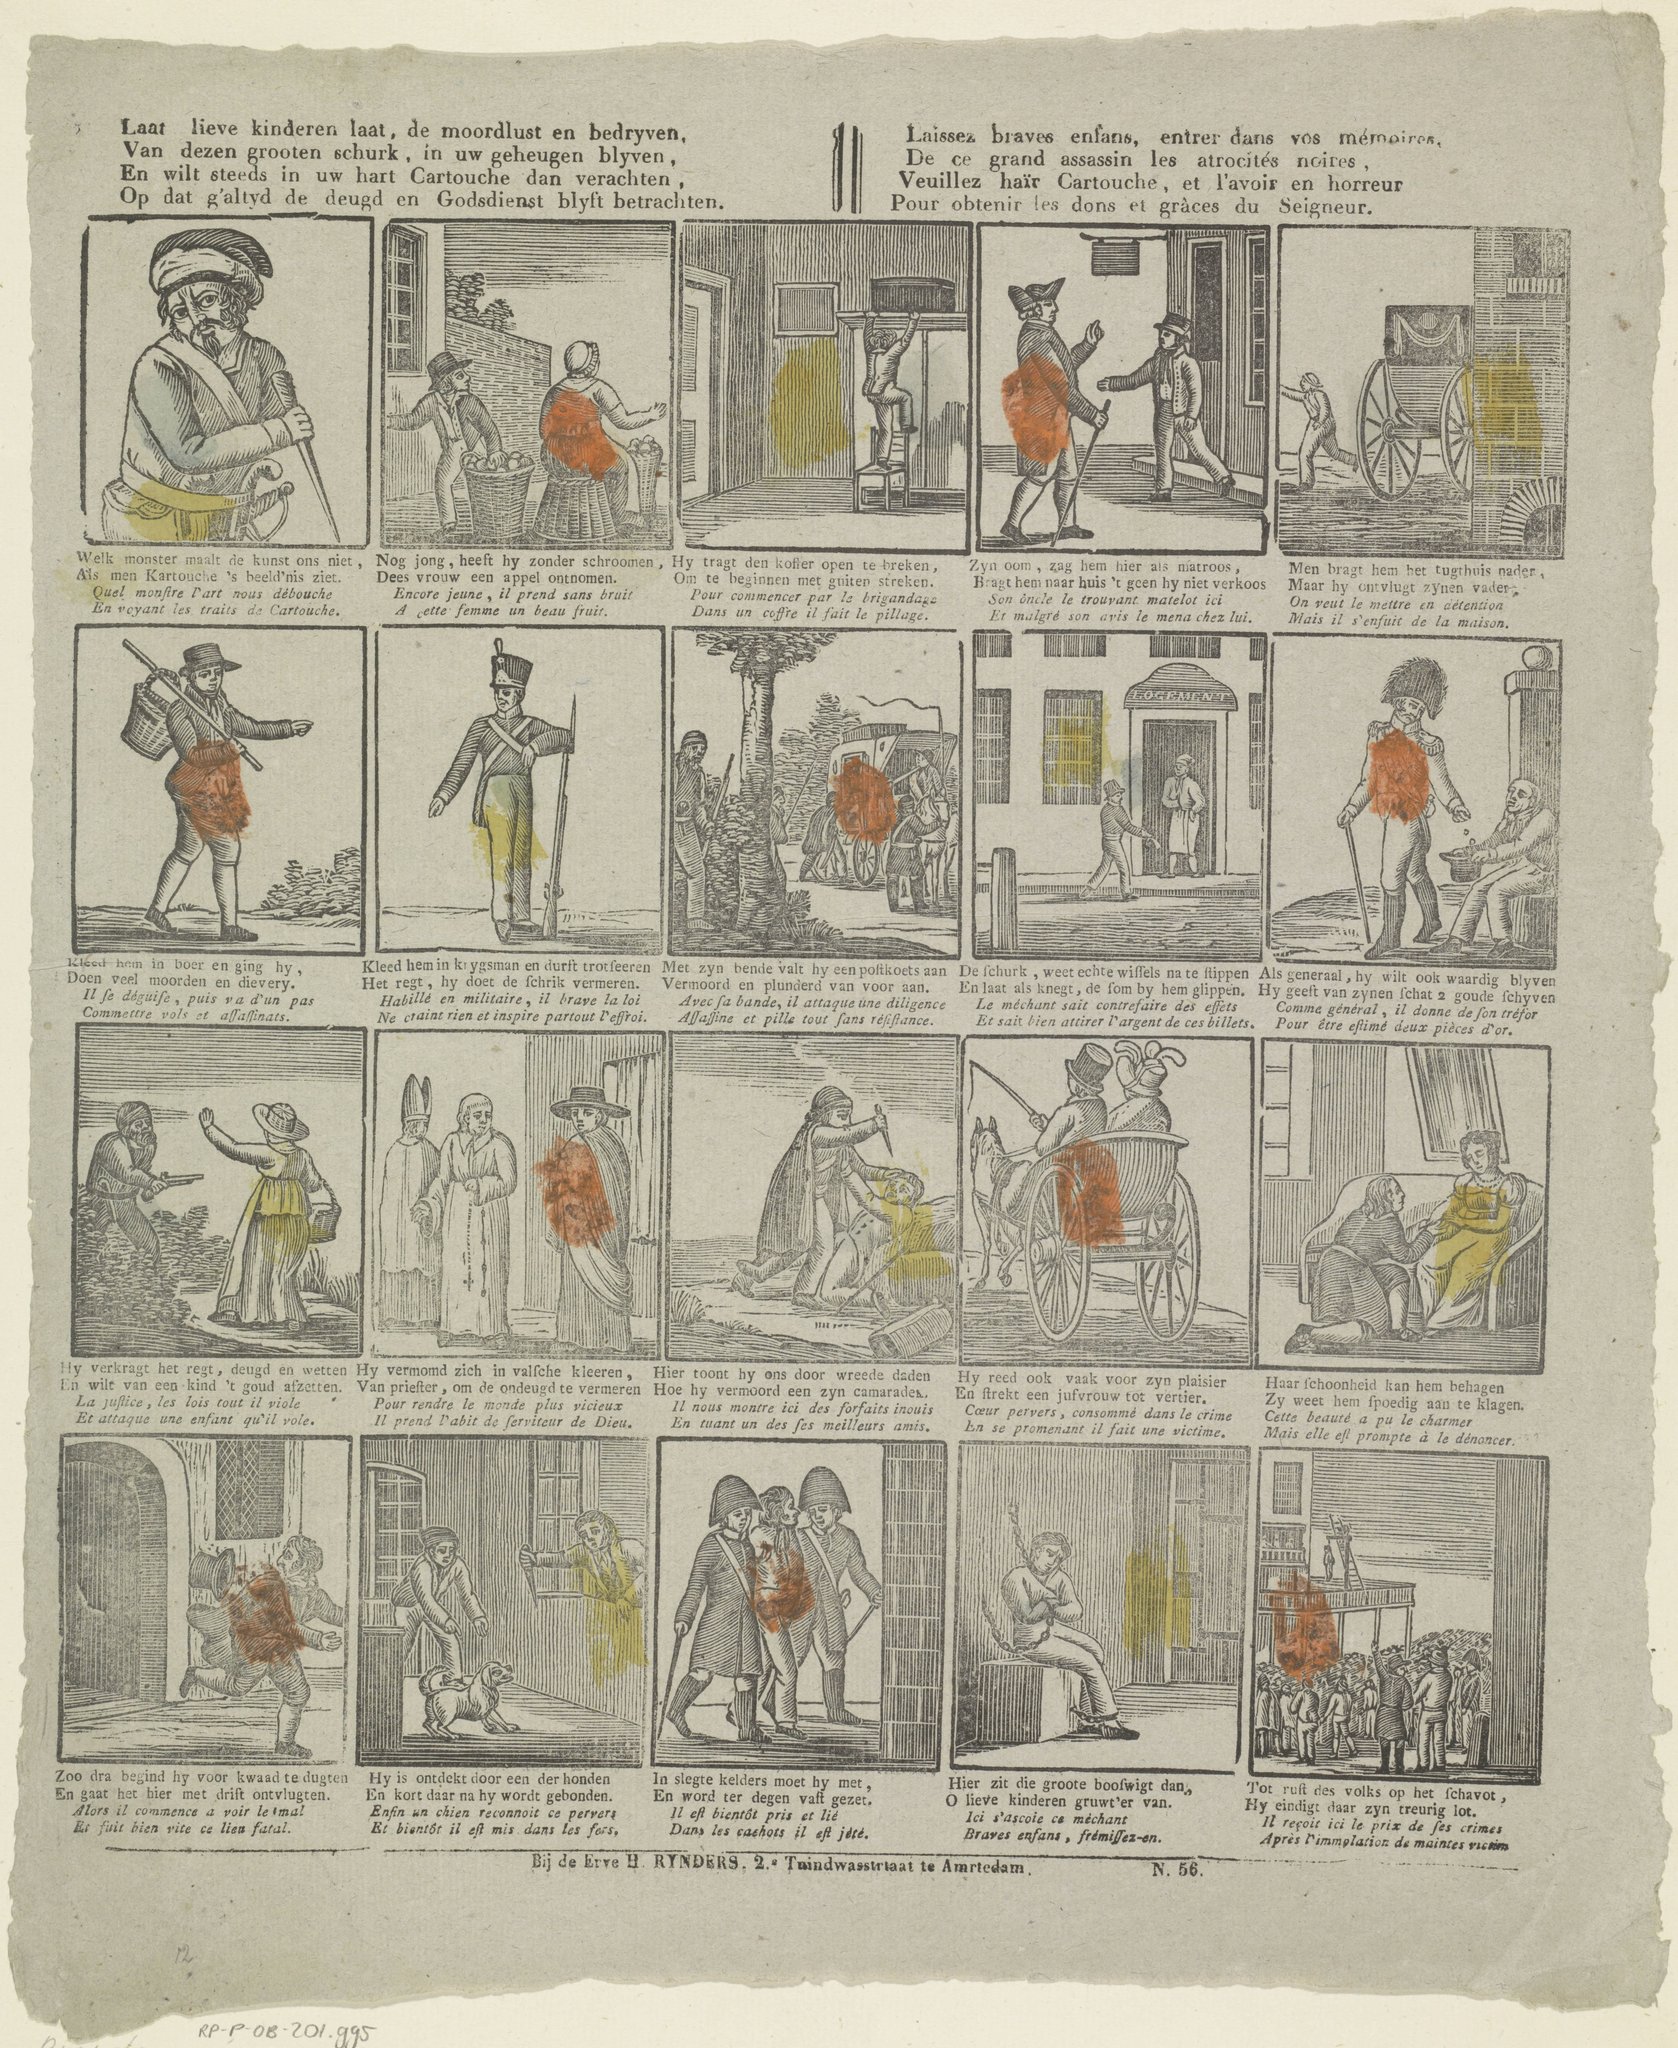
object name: print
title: Laat lieve kindren laat, de moordlust en bedryven / Van dezen grooten schurk, in uw geheugen blyven [(...)]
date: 1800-1854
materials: paper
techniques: colour, letterpress printing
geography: turnhout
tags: violent death by hanging, bad behaviour, tales and fairy tales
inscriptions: collector's mark: Lugt 2760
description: Blad met 20 voorstellingen over het leven en avonturen van Cartouche. Onder elke afbeelding een tweeregelig vers in het Nederlands en in het Frans. Genummerd rechtsonder: N. 56.